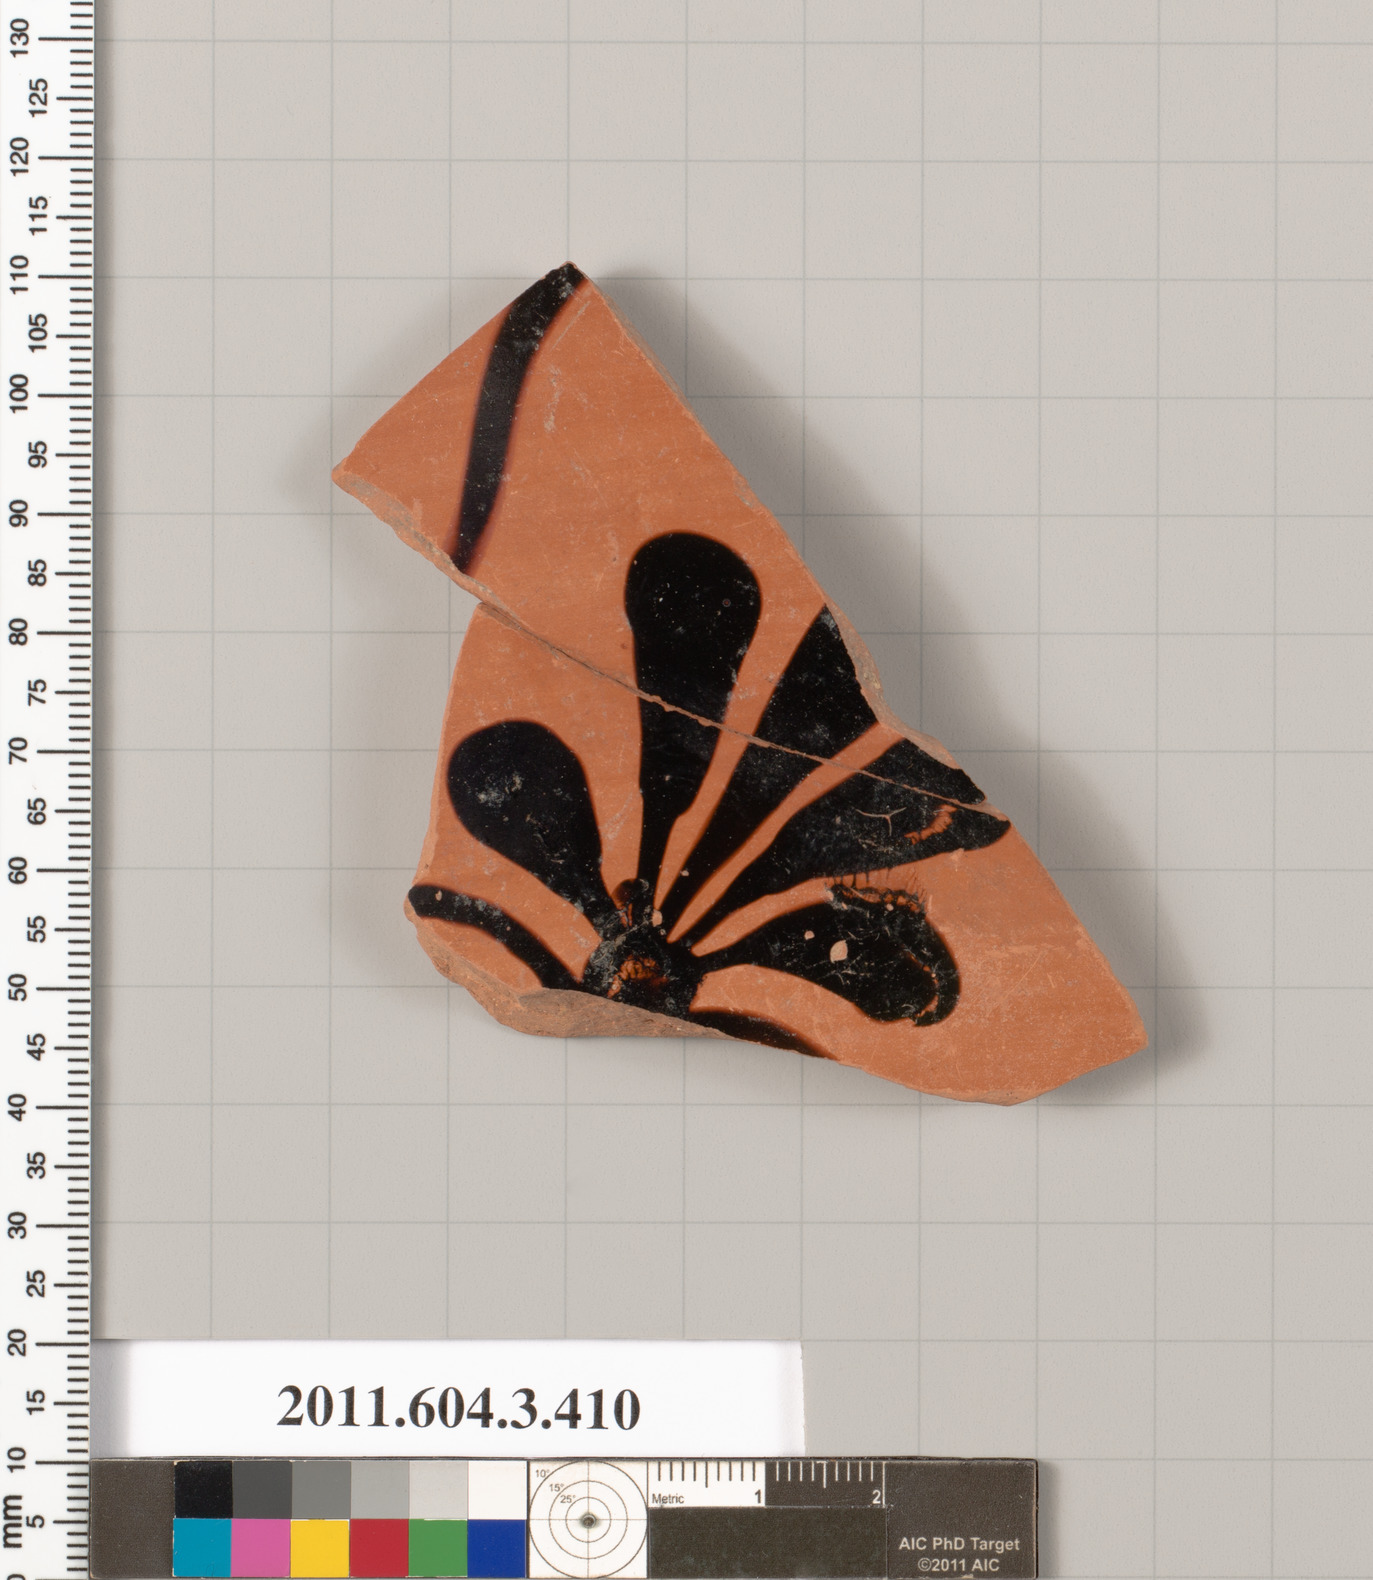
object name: neck amphora fragment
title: Terracotta fragment of a neck-amphora (jar)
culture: greek, attic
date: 500-468 BCE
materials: terracotta